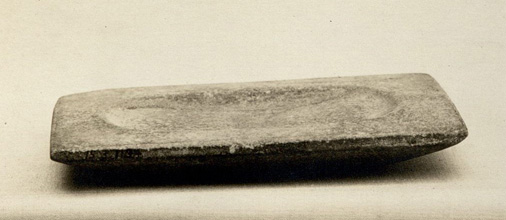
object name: inkwell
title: Palette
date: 1981-1640 BCE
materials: stone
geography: egypt